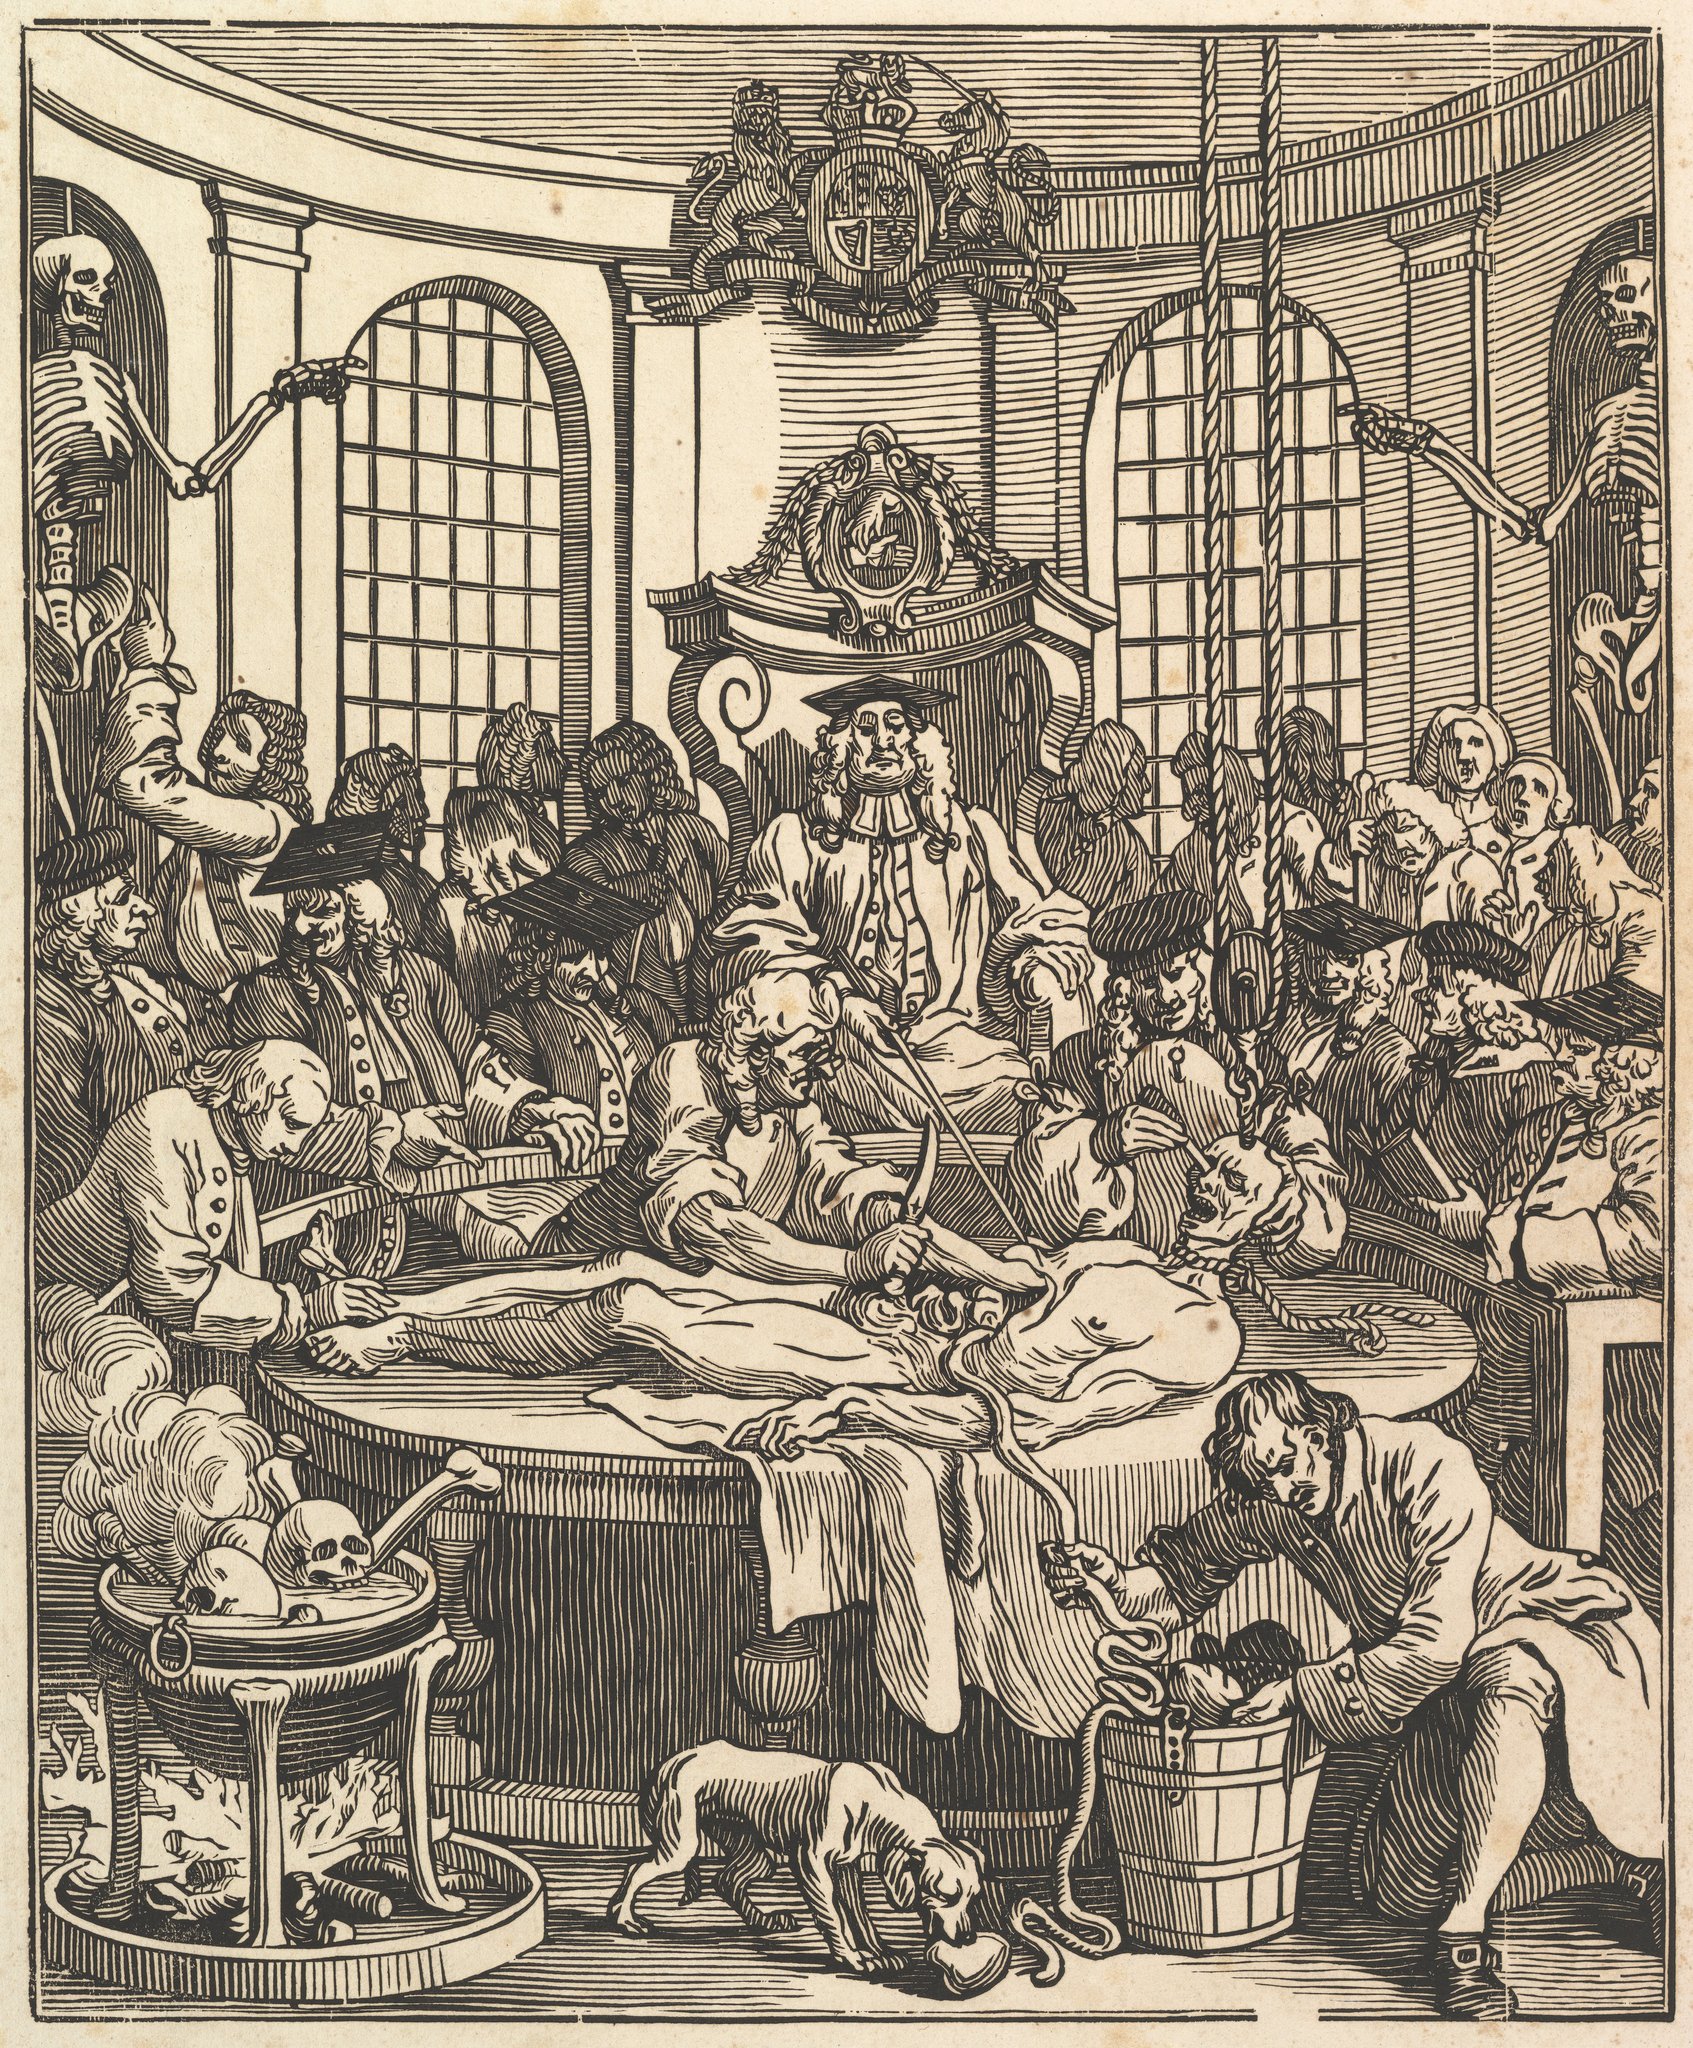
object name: print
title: The Reward of Cruelty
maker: john bell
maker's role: printmaker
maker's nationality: british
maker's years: 1750-1780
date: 1790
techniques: woodcut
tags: human figures,skeletons,suffering,dogs